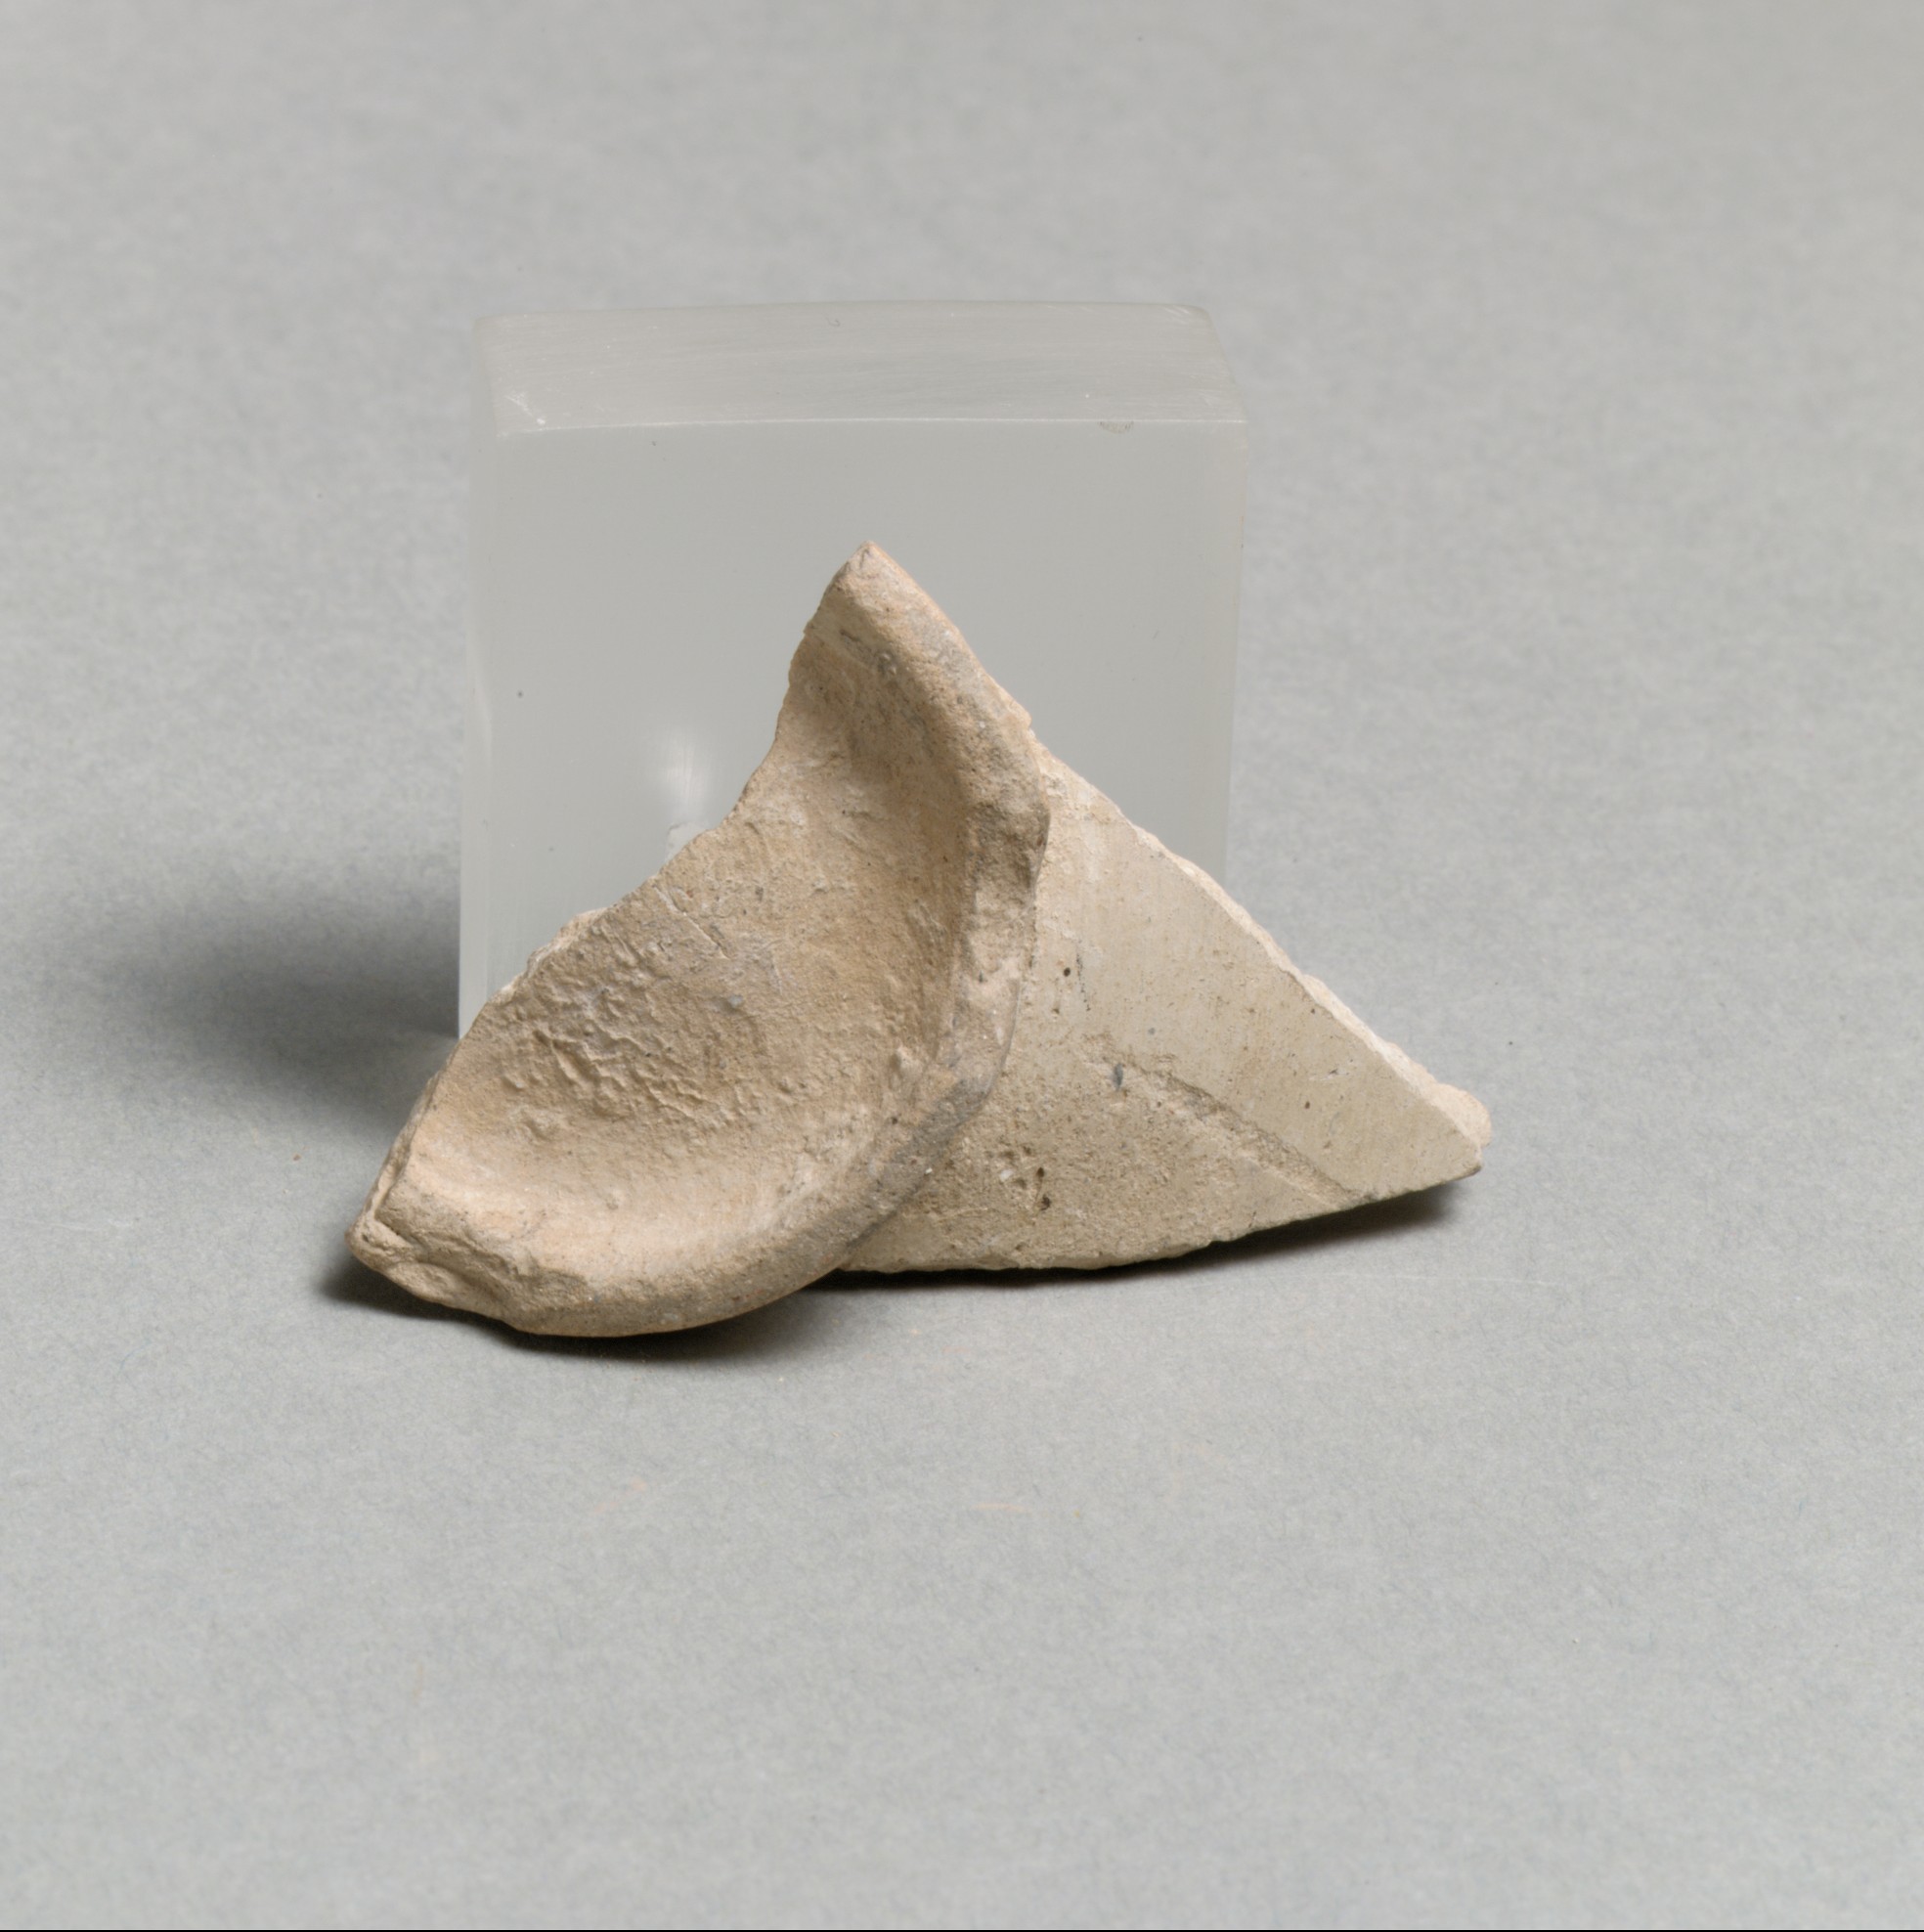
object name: vase fragment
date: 3000-2200 BCE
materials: terracotta